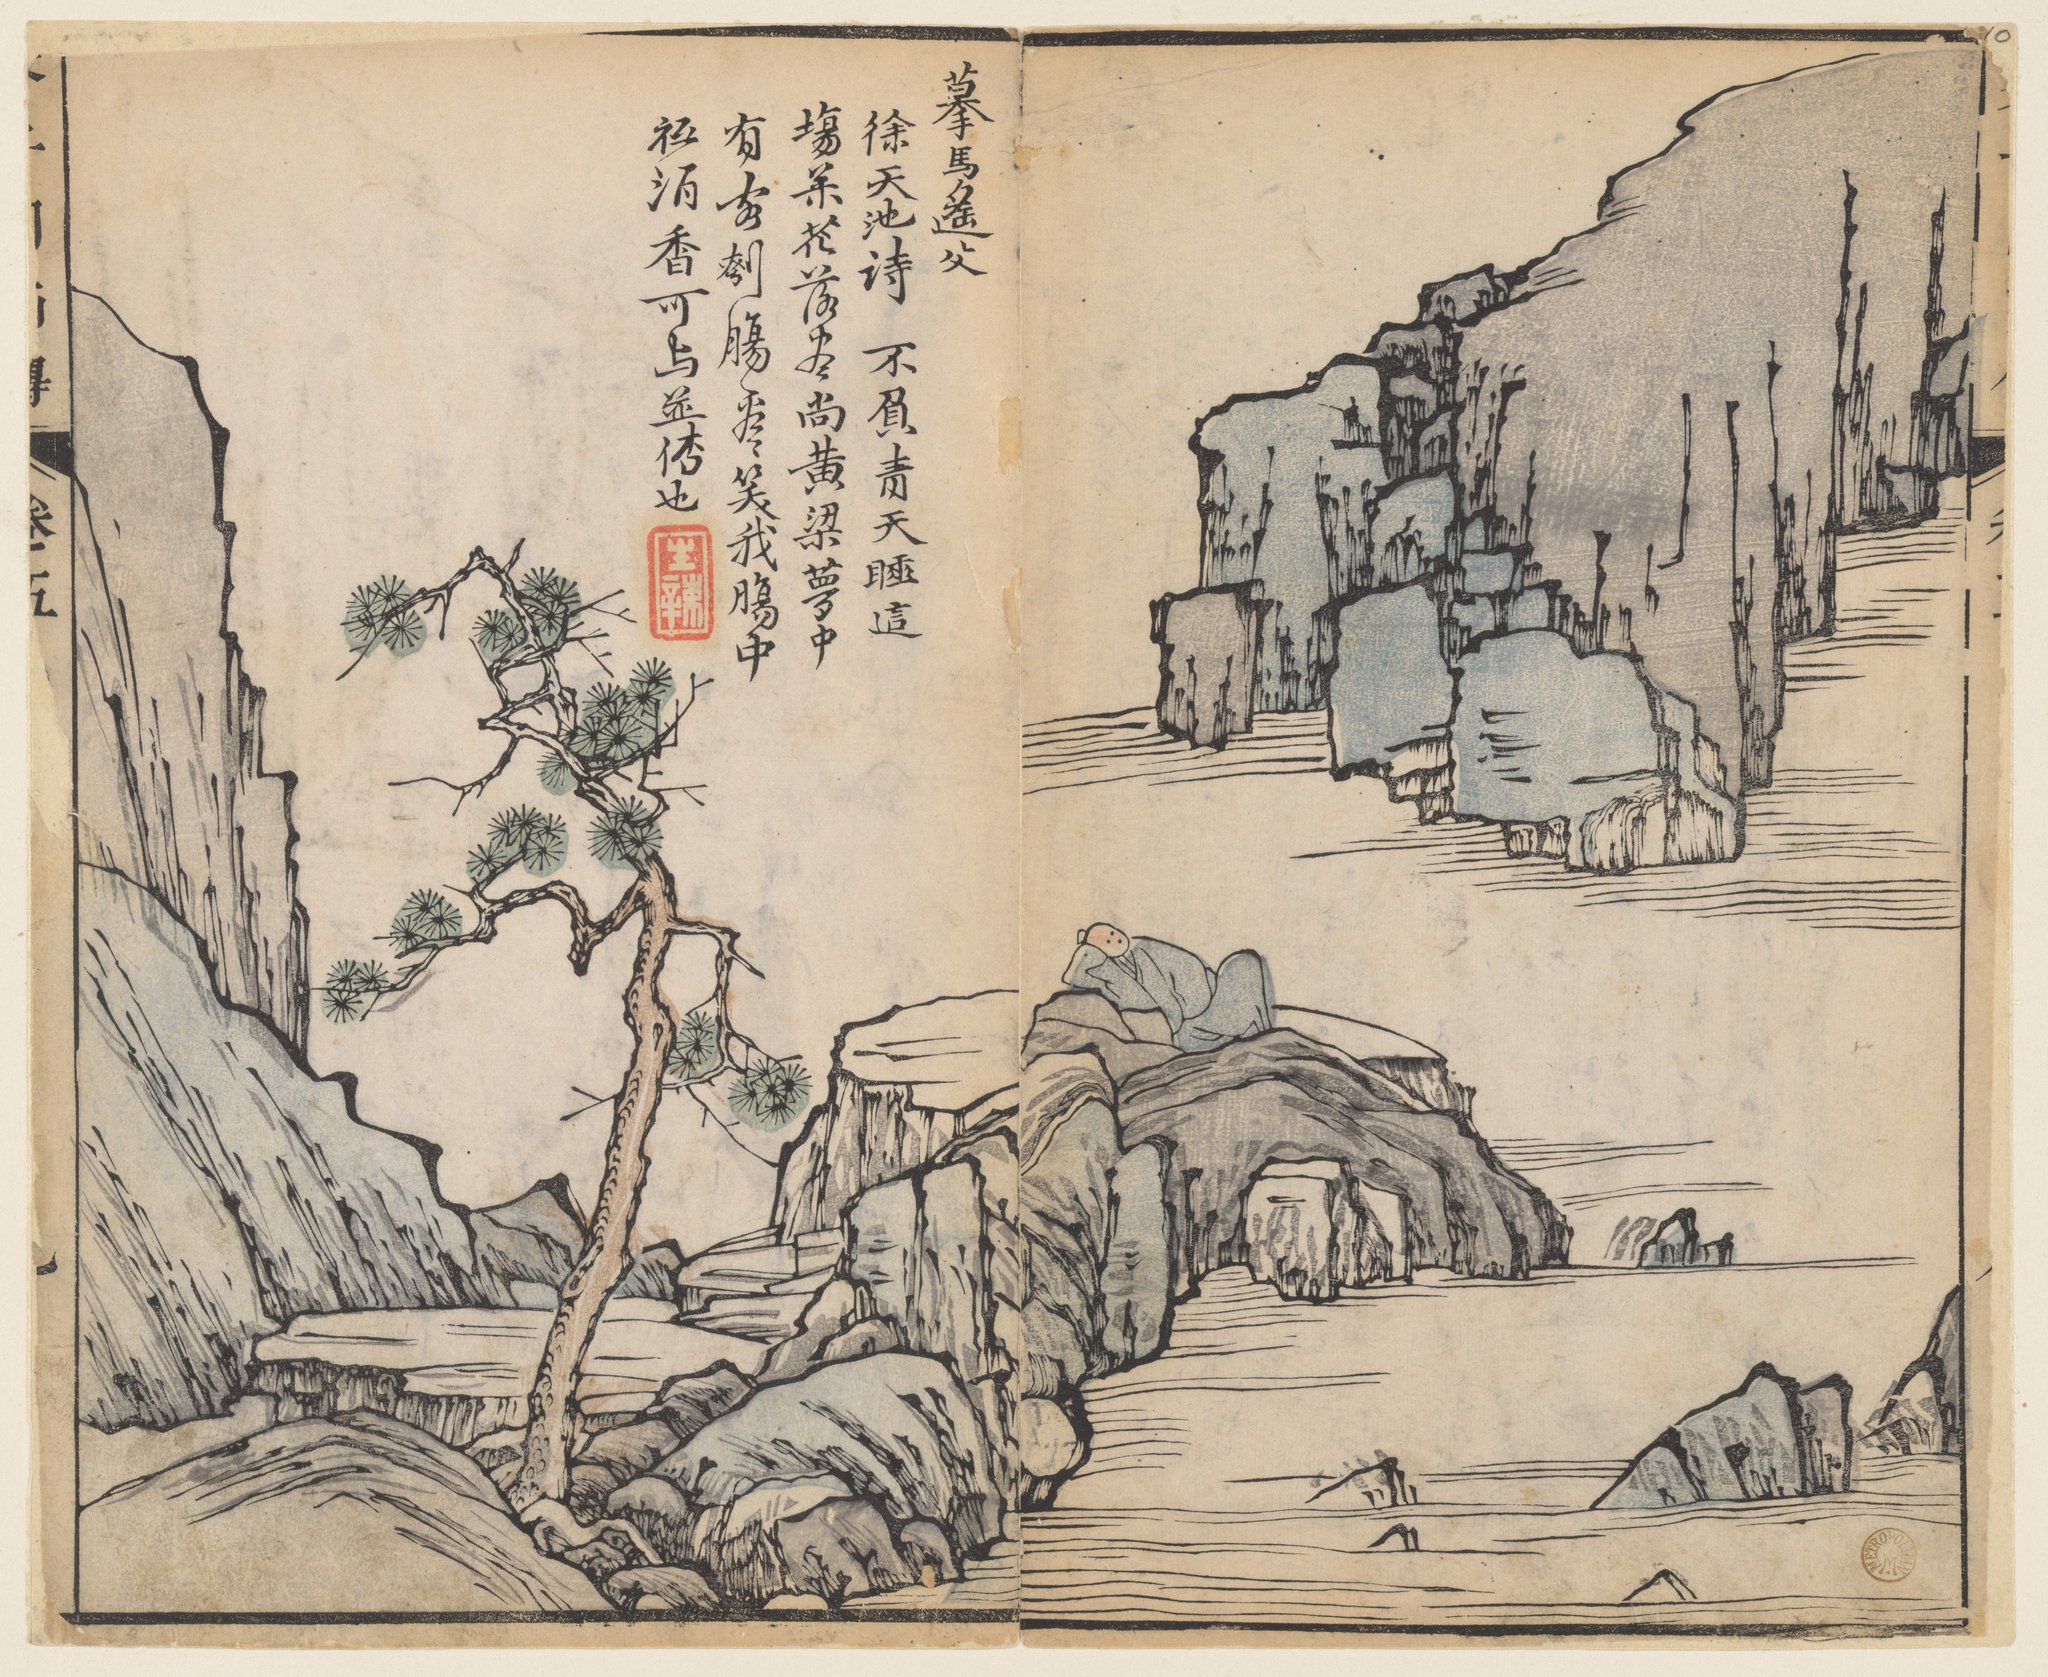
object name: print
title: Page from the Mustard Seed Garden Manual of Painting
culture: chinese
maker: wang gai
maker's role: artist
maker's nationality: chinese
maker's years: 1645-1710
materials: ink, paper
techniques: woodblock print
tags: mountains,landscapes